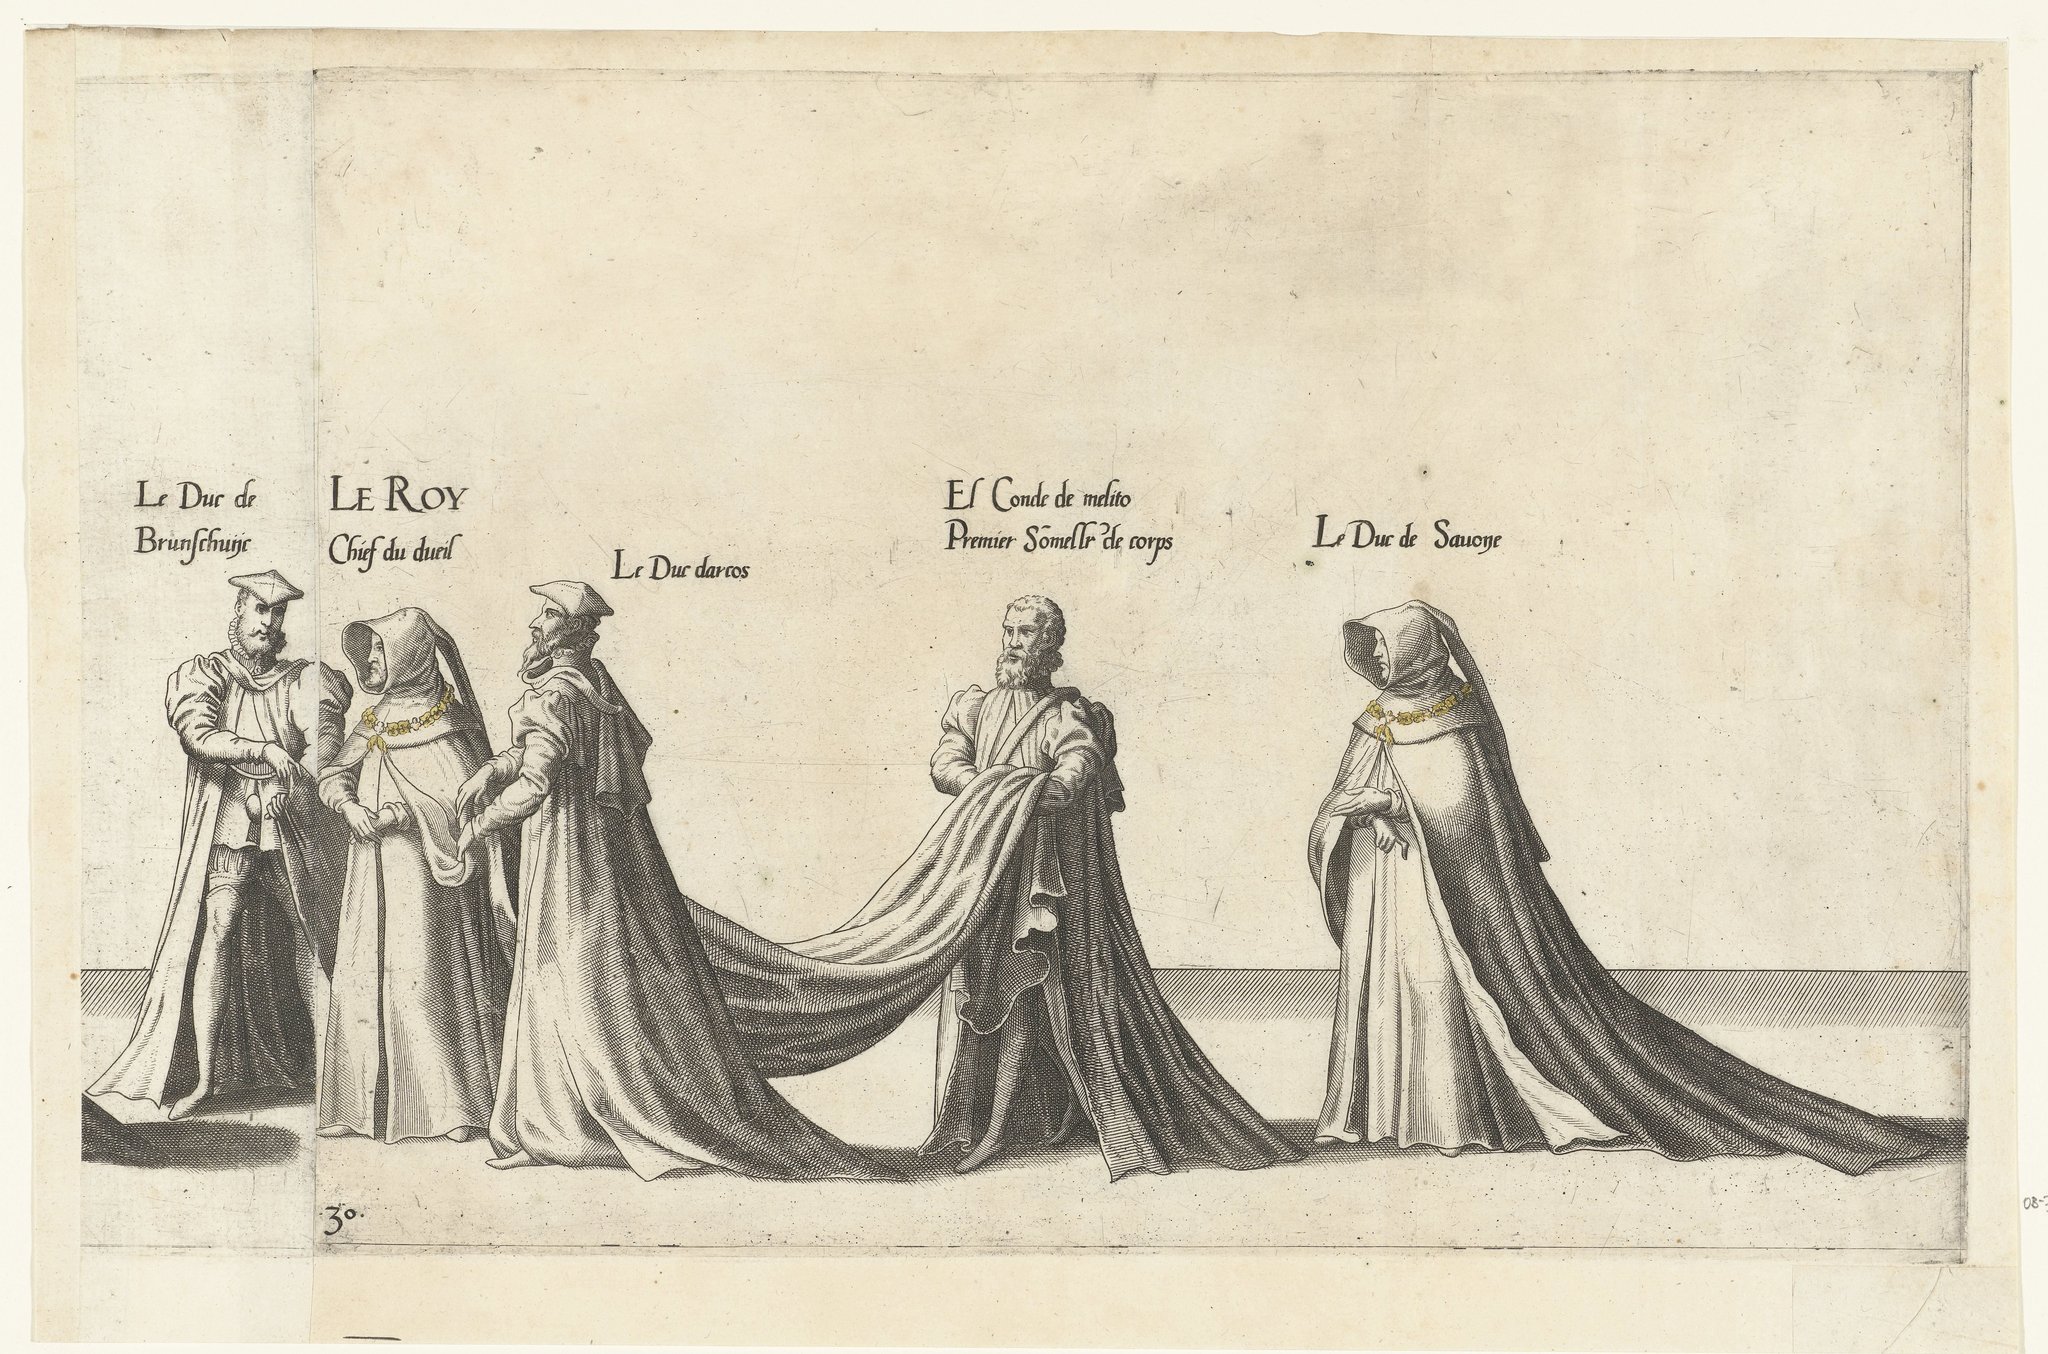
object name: print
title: Begrafenisoptocht van keizer Karel V, 1558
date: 1559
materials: paper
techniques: engraving, etching, hand coloring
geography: southern netherlands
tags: philip ii of spain, charles v (holy roman emperor and king of spain), cortege, funeral procession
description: Vier edelen die deelnemen aan de optocht, waaronder Filips II. Onderdeel van de prentreeks van de Begrafenisoptocht van keizer Karel V op 29 december 1558 te Brussel. Links is een strook van prent nr. 29 met één persoon aangeplakt.